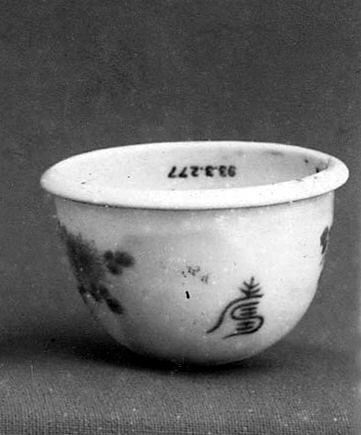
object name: wine cup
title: Nesting Wine Cup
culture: japanese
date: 1820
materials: glaze, porcelain